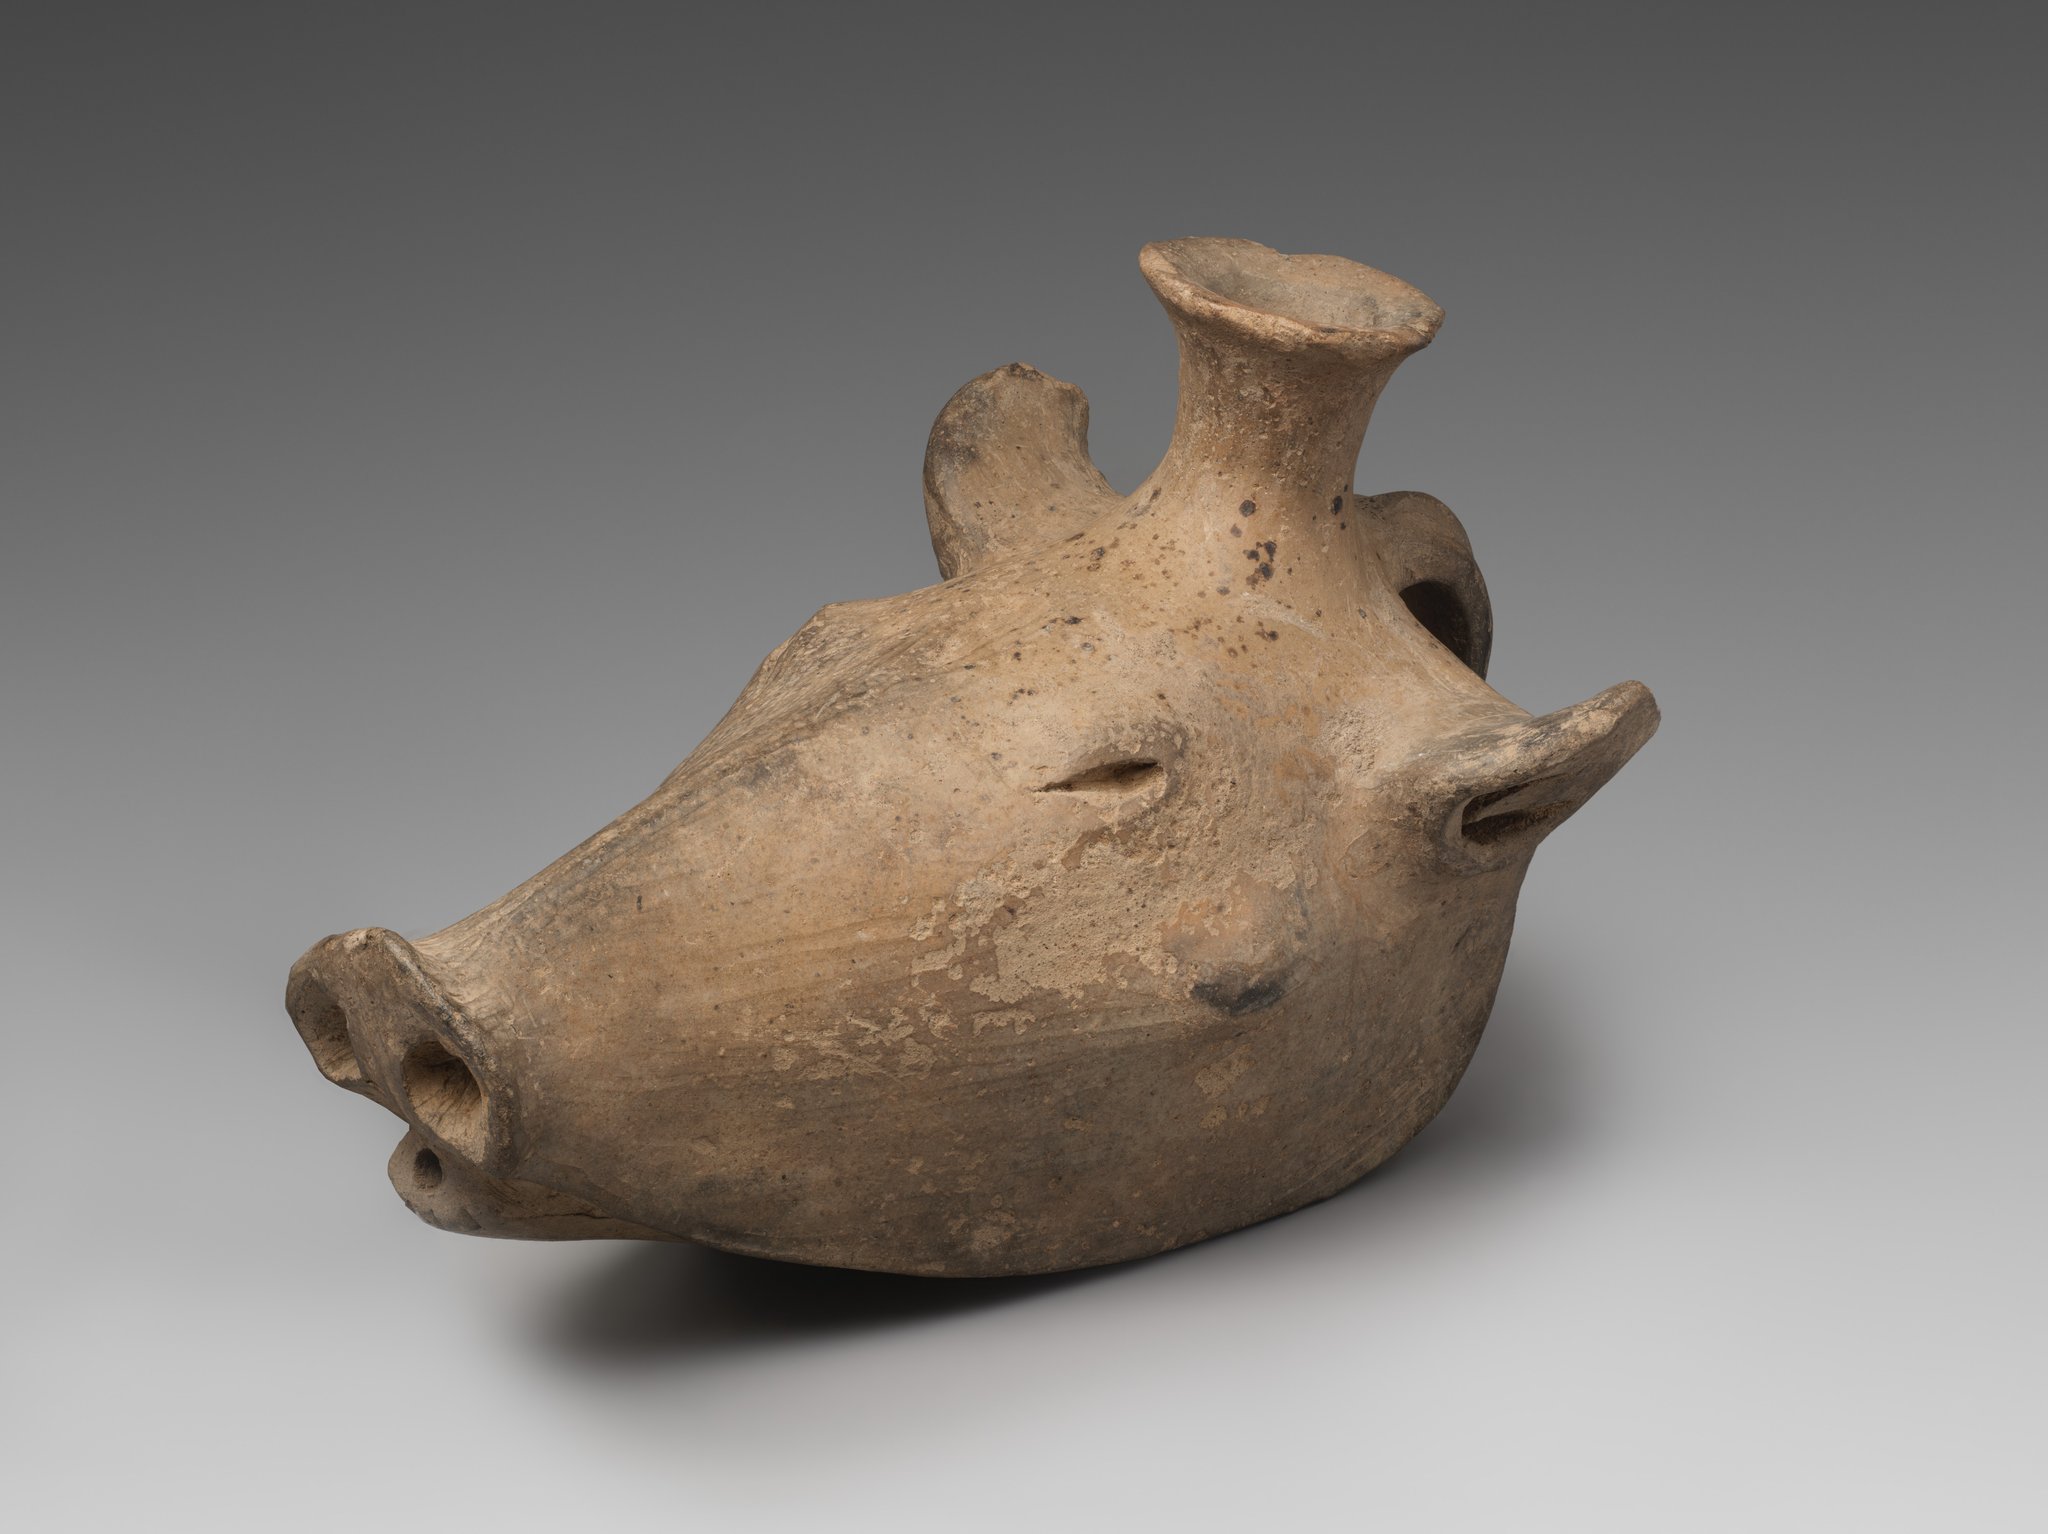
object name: rhyton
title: Rhyton in the shape of a boar head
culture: iranian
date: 1000-1 BCE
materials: ceramic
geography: northwestern iran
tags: boars